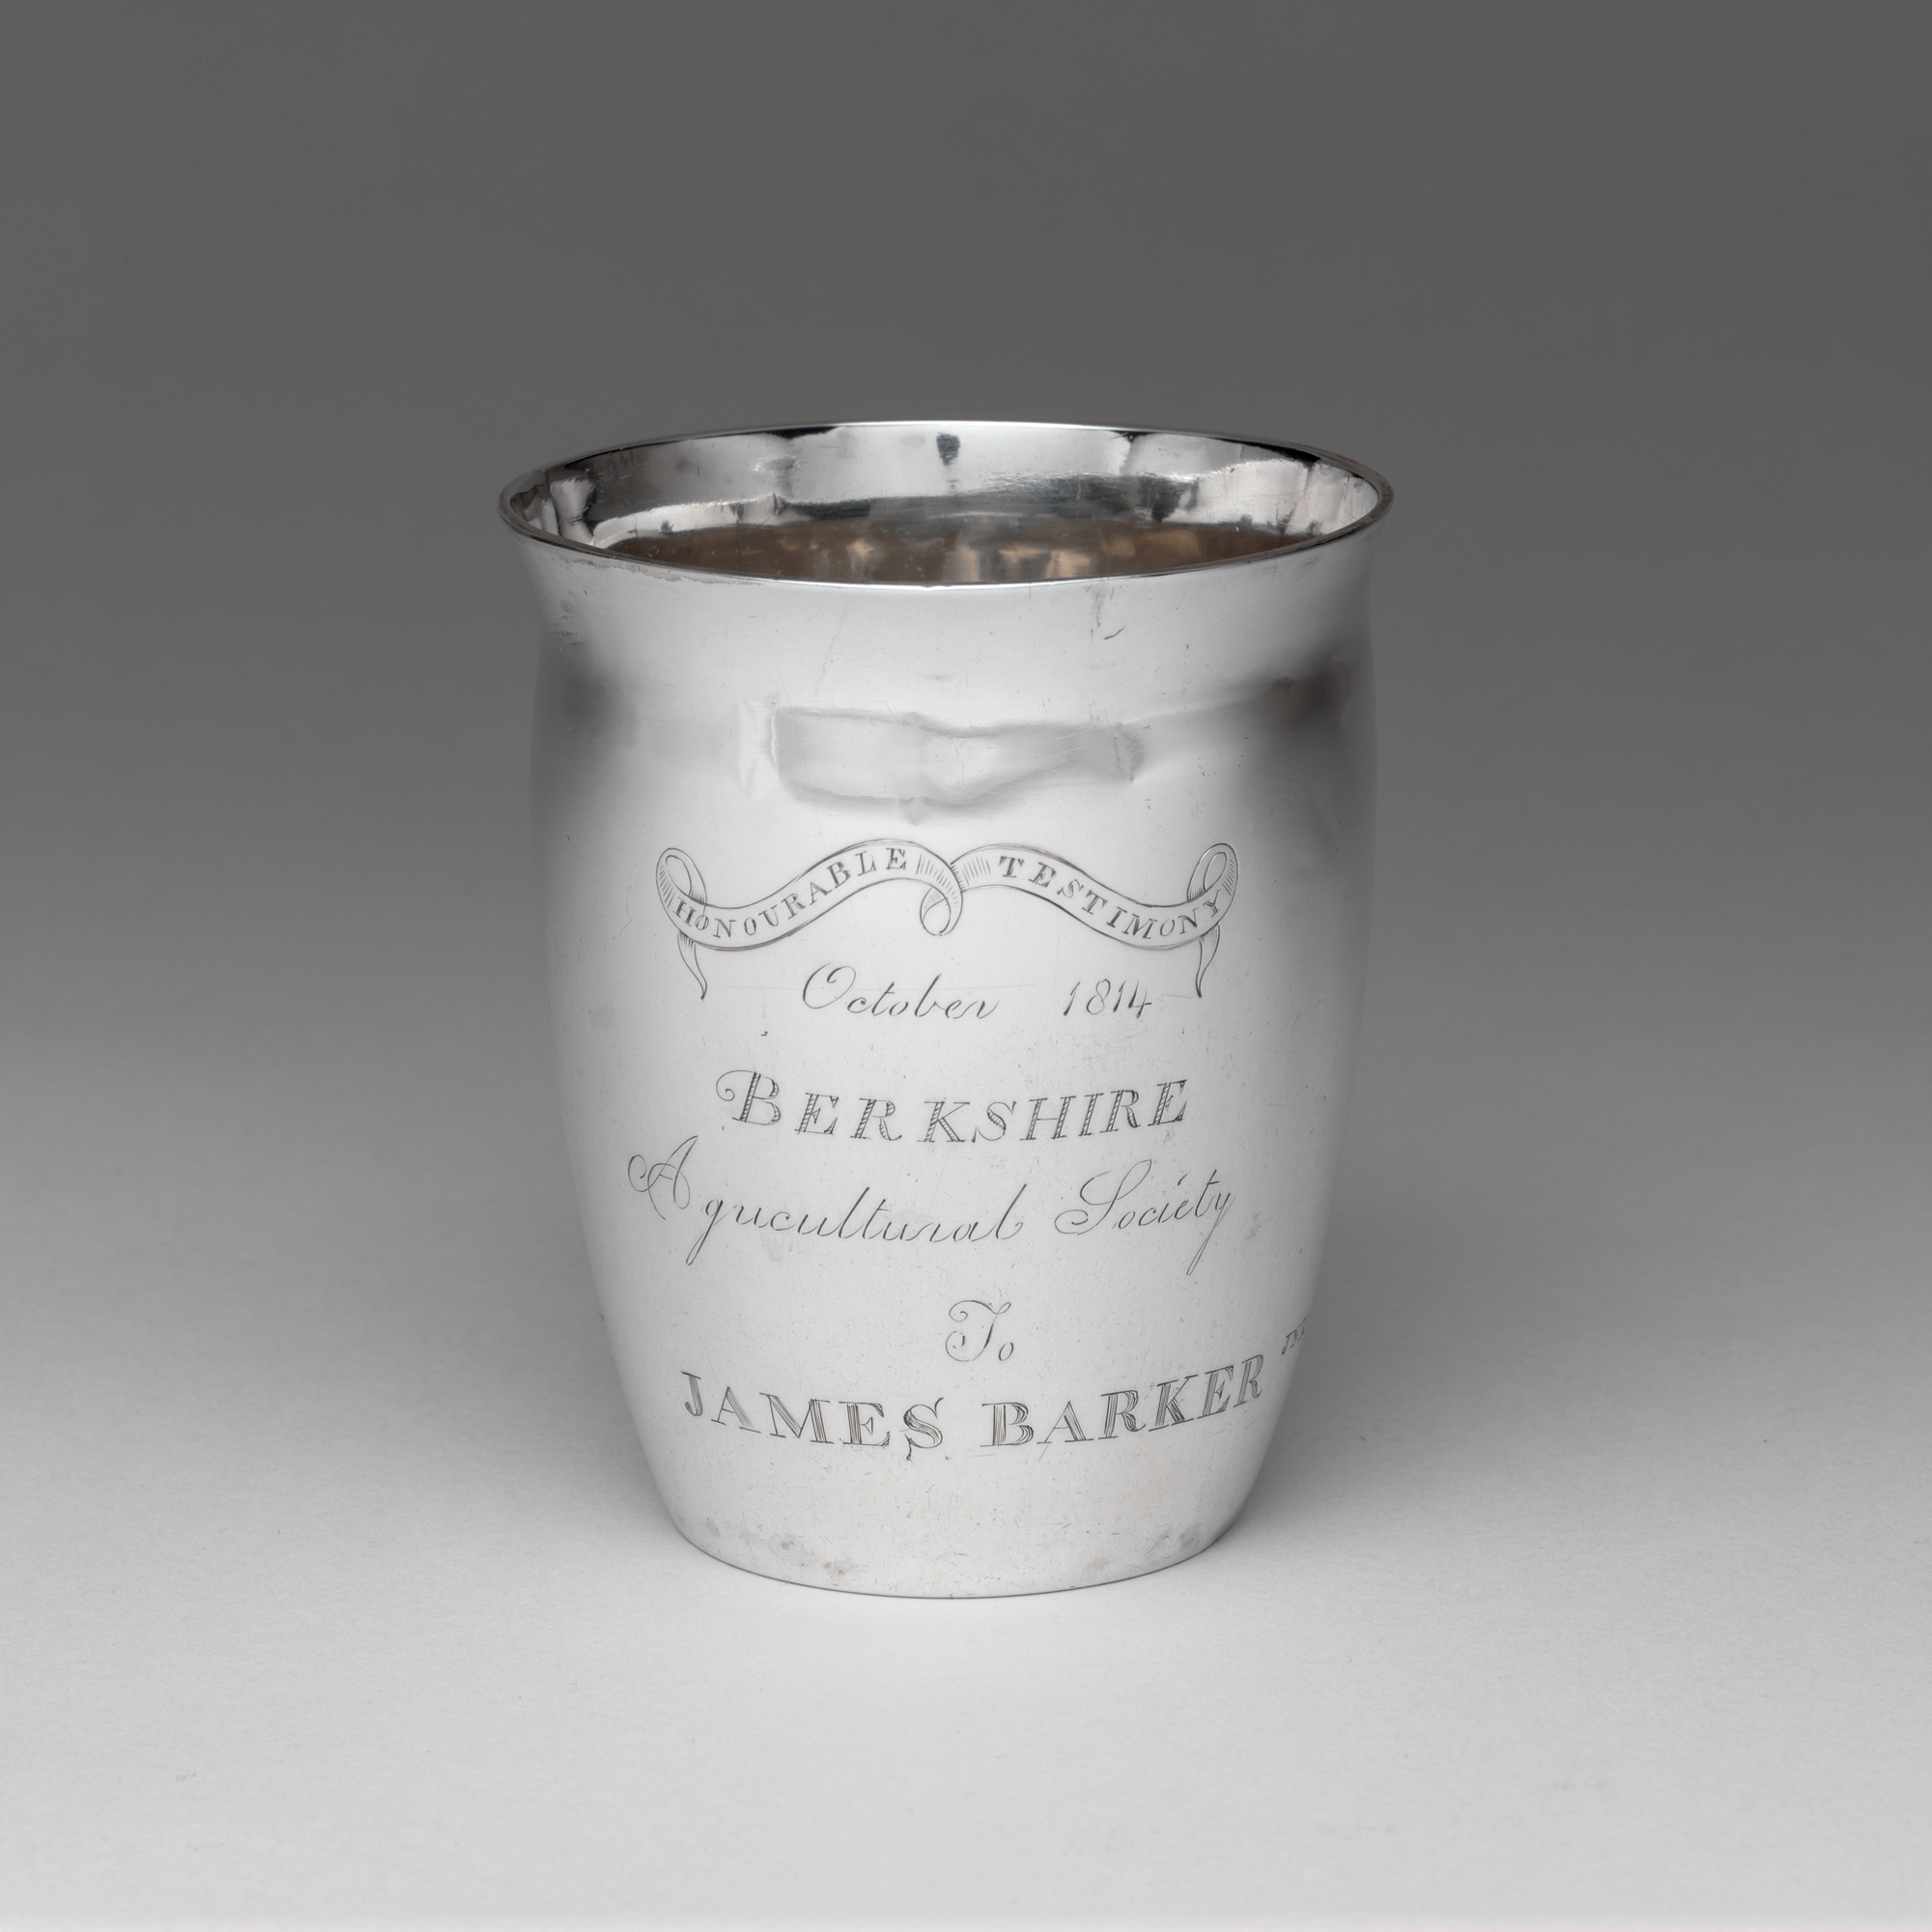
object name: beaker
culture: american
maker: shepherd and boyd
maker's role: maker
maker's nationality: american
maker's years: 1806-1830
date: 1814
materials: silver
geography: united states